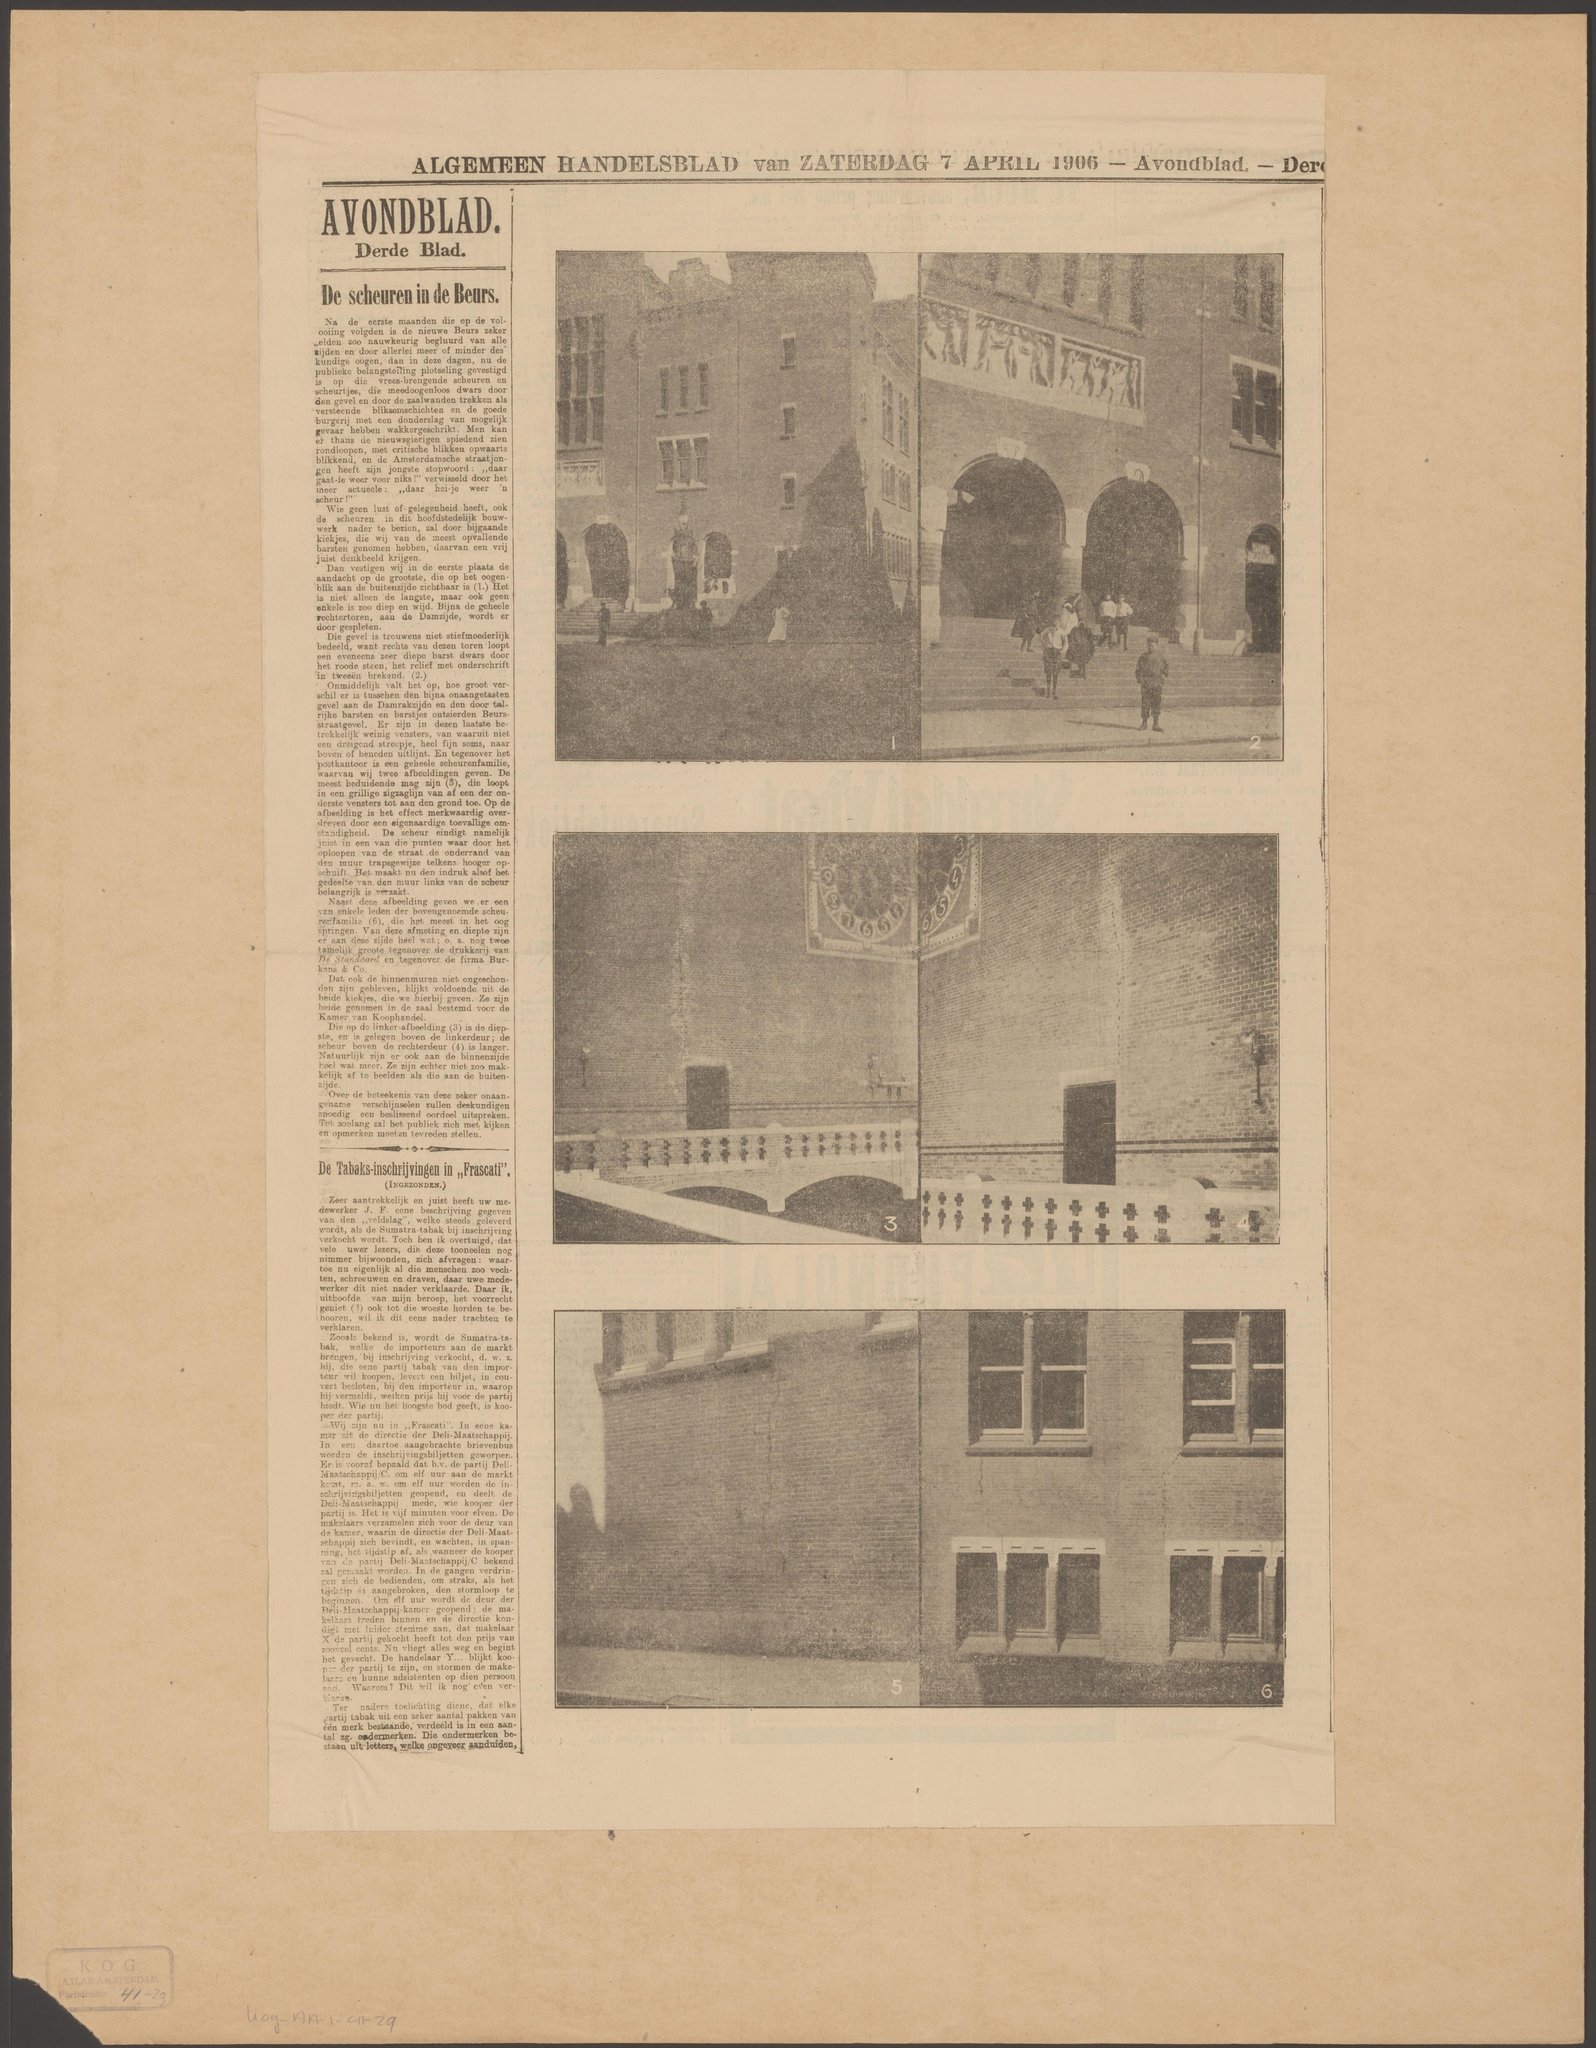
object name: photomechanical print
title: Scheuren in de Beurs van Berlage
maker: Anonymous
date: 1906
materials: paper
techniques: letterpress printing, offset printed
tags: stock exchange, stock-market, amsterdam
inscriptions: collector's mark: Lugt 1461b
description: Onderwerpsrubriek binnen de Atlas Amsterdam: B. Beurs op het Damrak.